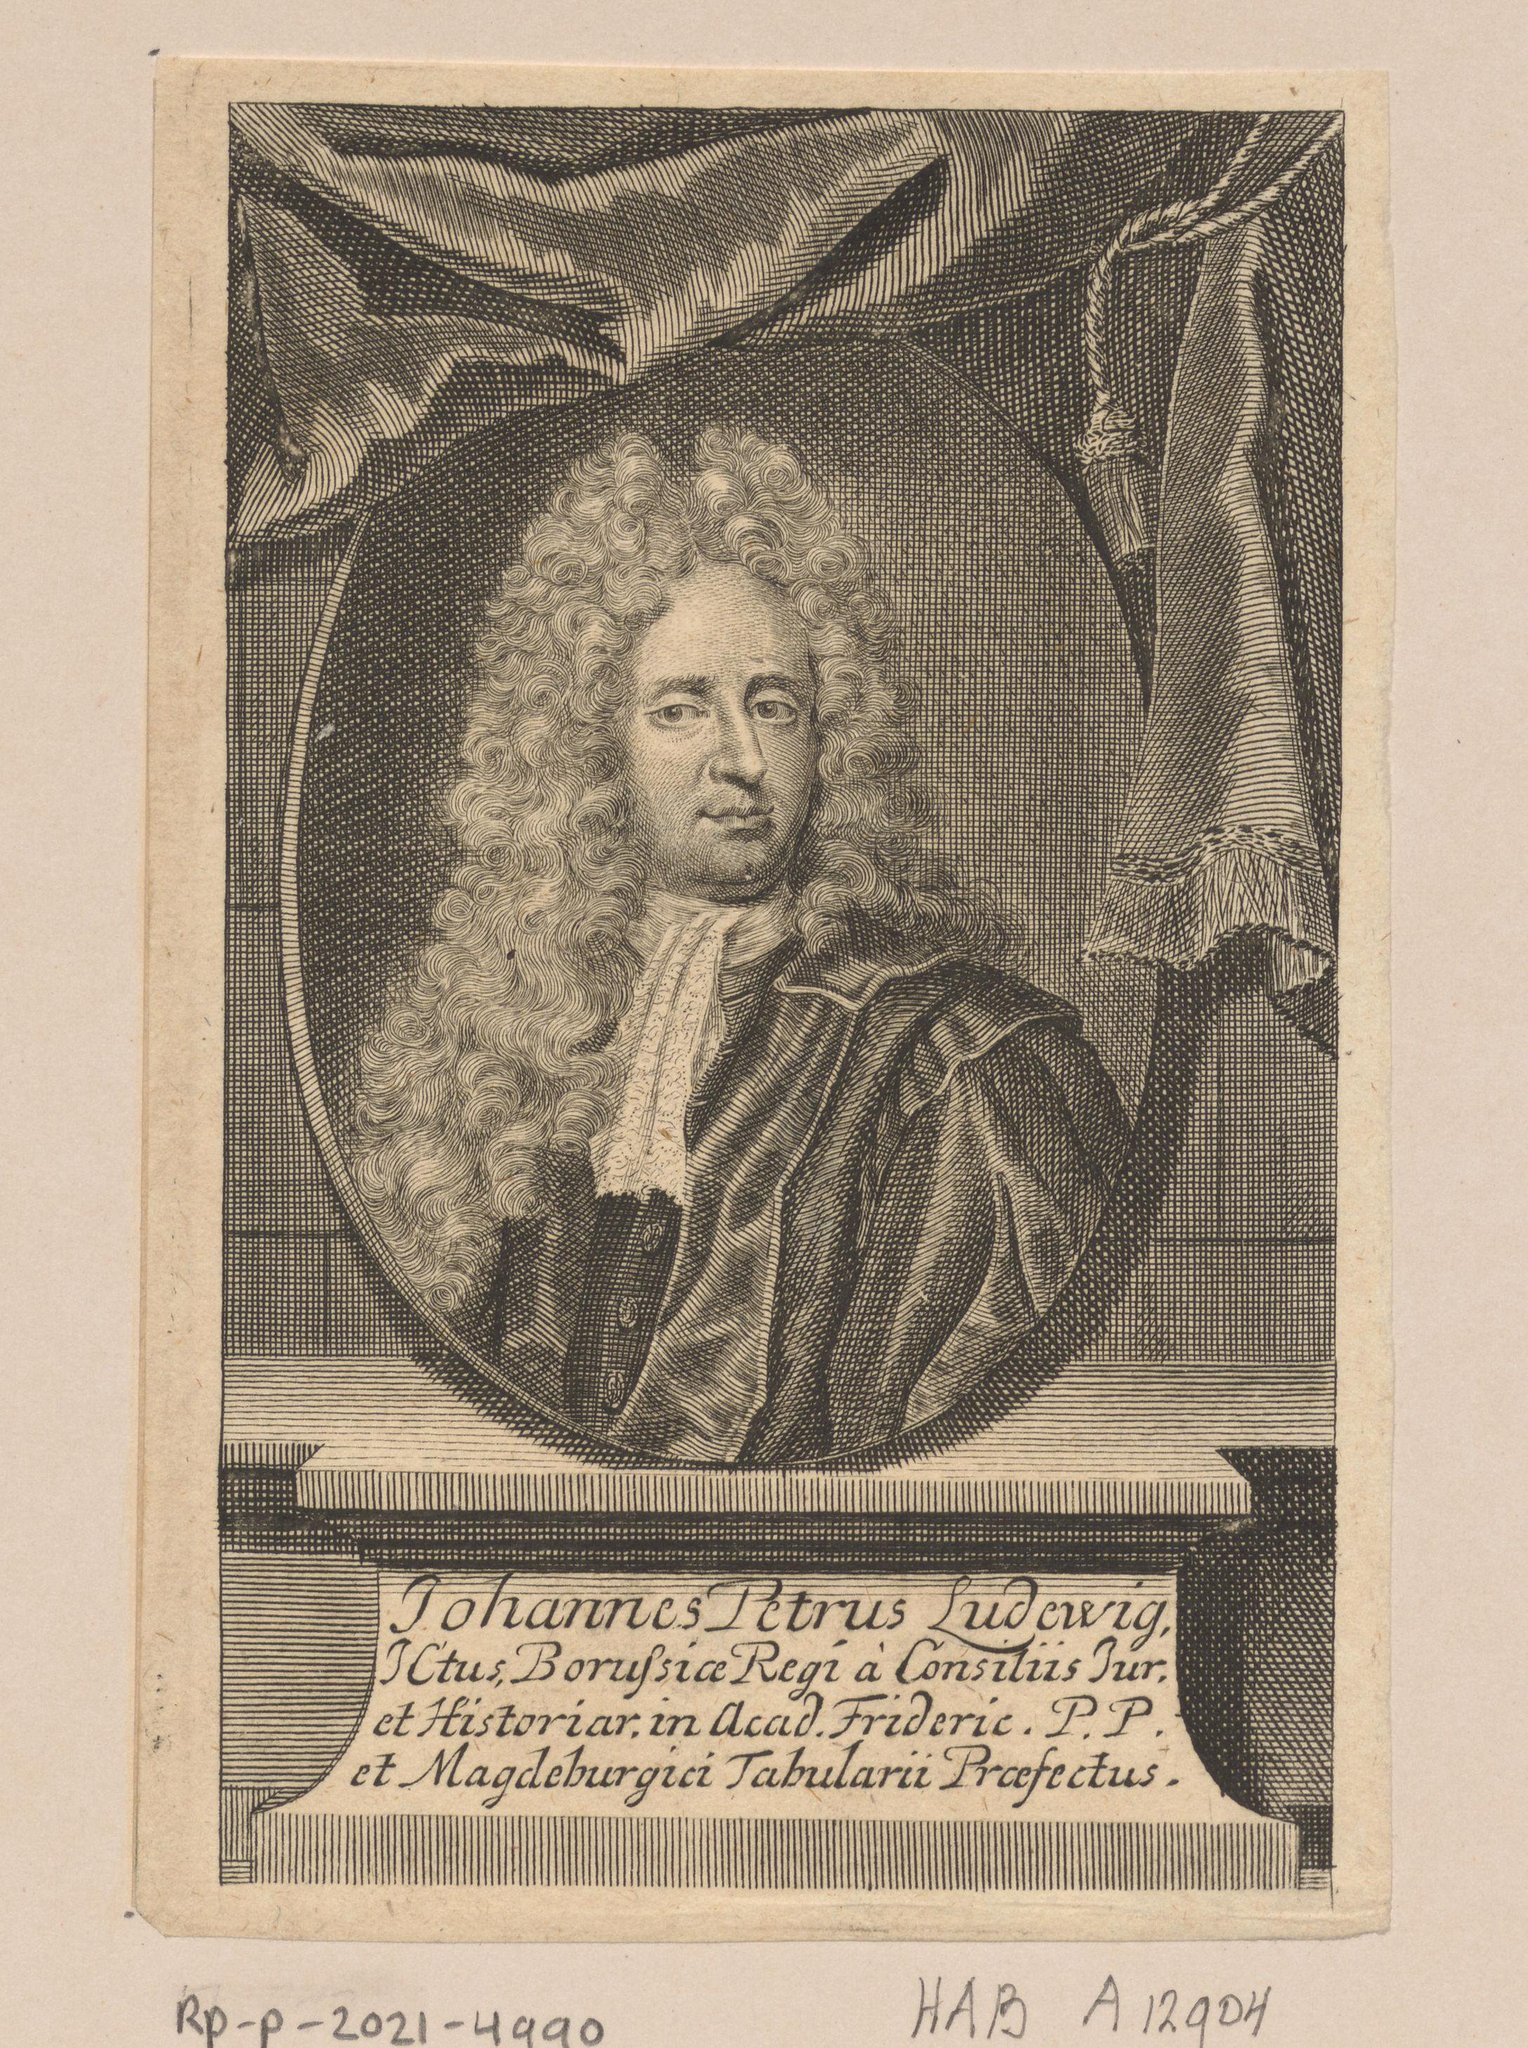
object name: book illustration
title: Portret van Johann Peter von Ludewig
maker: martin bernigeroth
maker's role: print maker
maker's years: 1670-1733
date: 1715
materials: paper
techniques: engraving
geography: germany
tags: (feigned) picture curtain, ornament ~ medallion, historical persons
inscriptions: collector's mark: Lugt 2228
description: Prent waarschijnlijk uit: Neue Bibliothec Oder Nachricht und Urtheile von neuen Büchern Und allerhand zur Gelehrsamkeit dienenden Sachen. Frankfurt am Main en Leipzig: Johann Gottfried Renger, 1715, dl. 43.